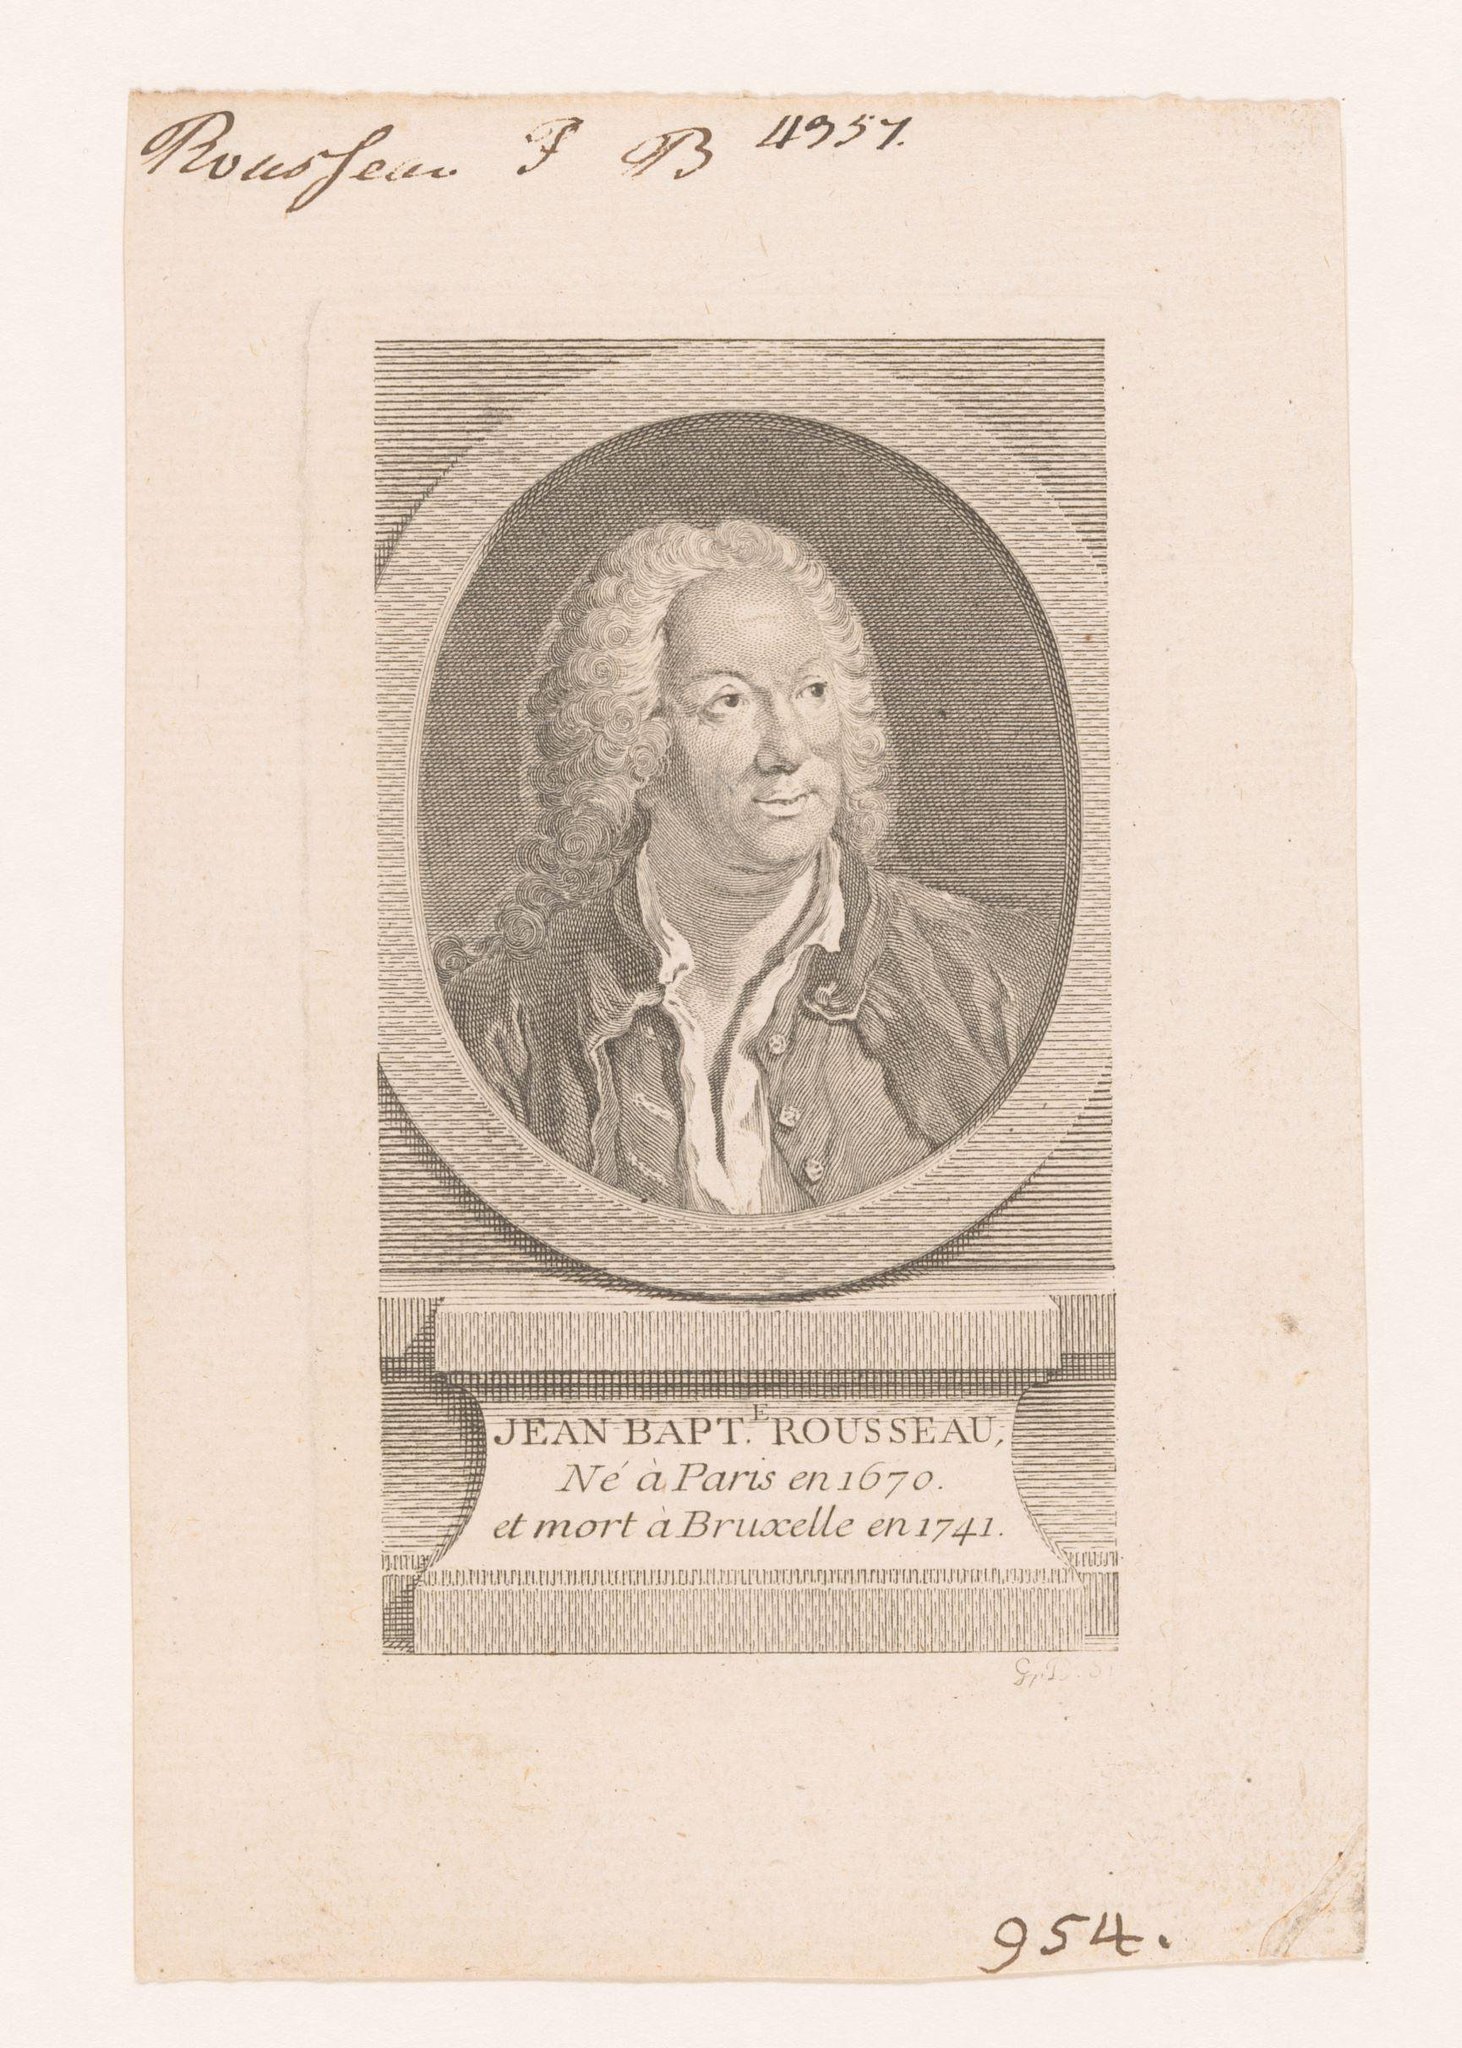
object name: print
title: Portret van Jean Baptiste Rousseau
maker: monogrammist gpd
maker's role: print maker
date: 1741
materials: paper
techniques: etching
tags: paris, brussels, jean baptiste rousseau (1669-1741), historical persons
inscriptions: collector's mark: Lugt 2228